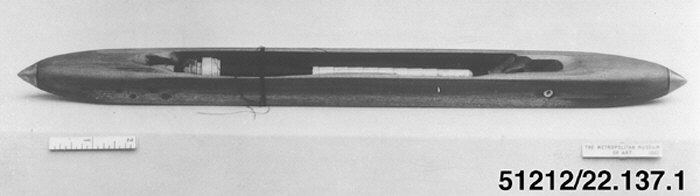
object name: shuttle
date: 1701-1800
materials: wood